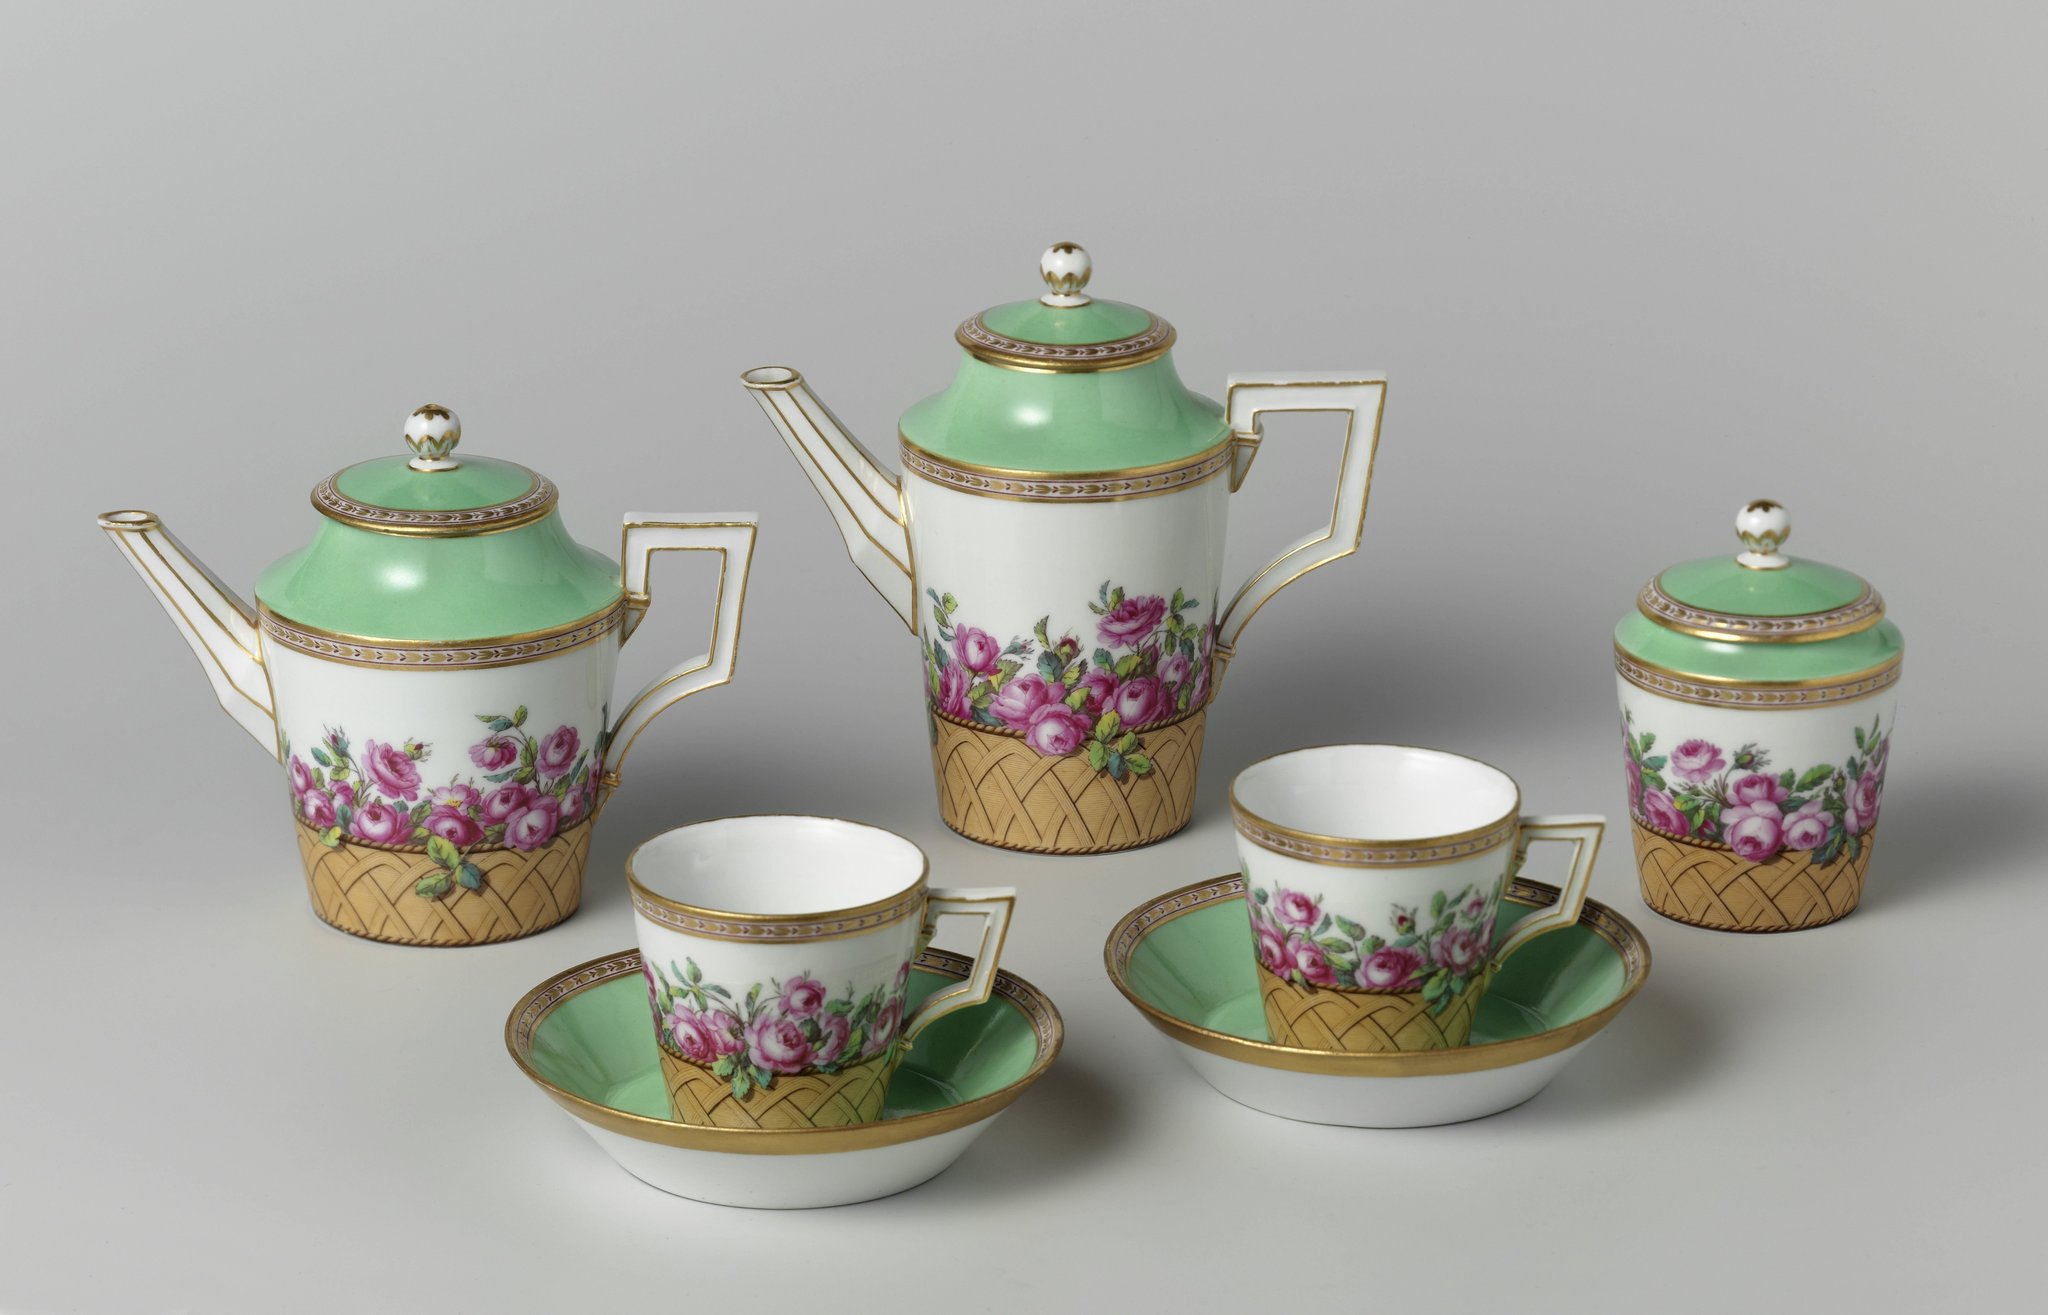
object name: tea service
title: Coffee and tea service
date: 1795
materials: glaze, gold, porcelain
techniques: firing, forming, gilding, turning, vitrification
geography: berlin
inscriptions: mark: ‘scepter’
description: Königliche Porzellan Manufaktur Berlin, c. 1795 hard-paste porcelain